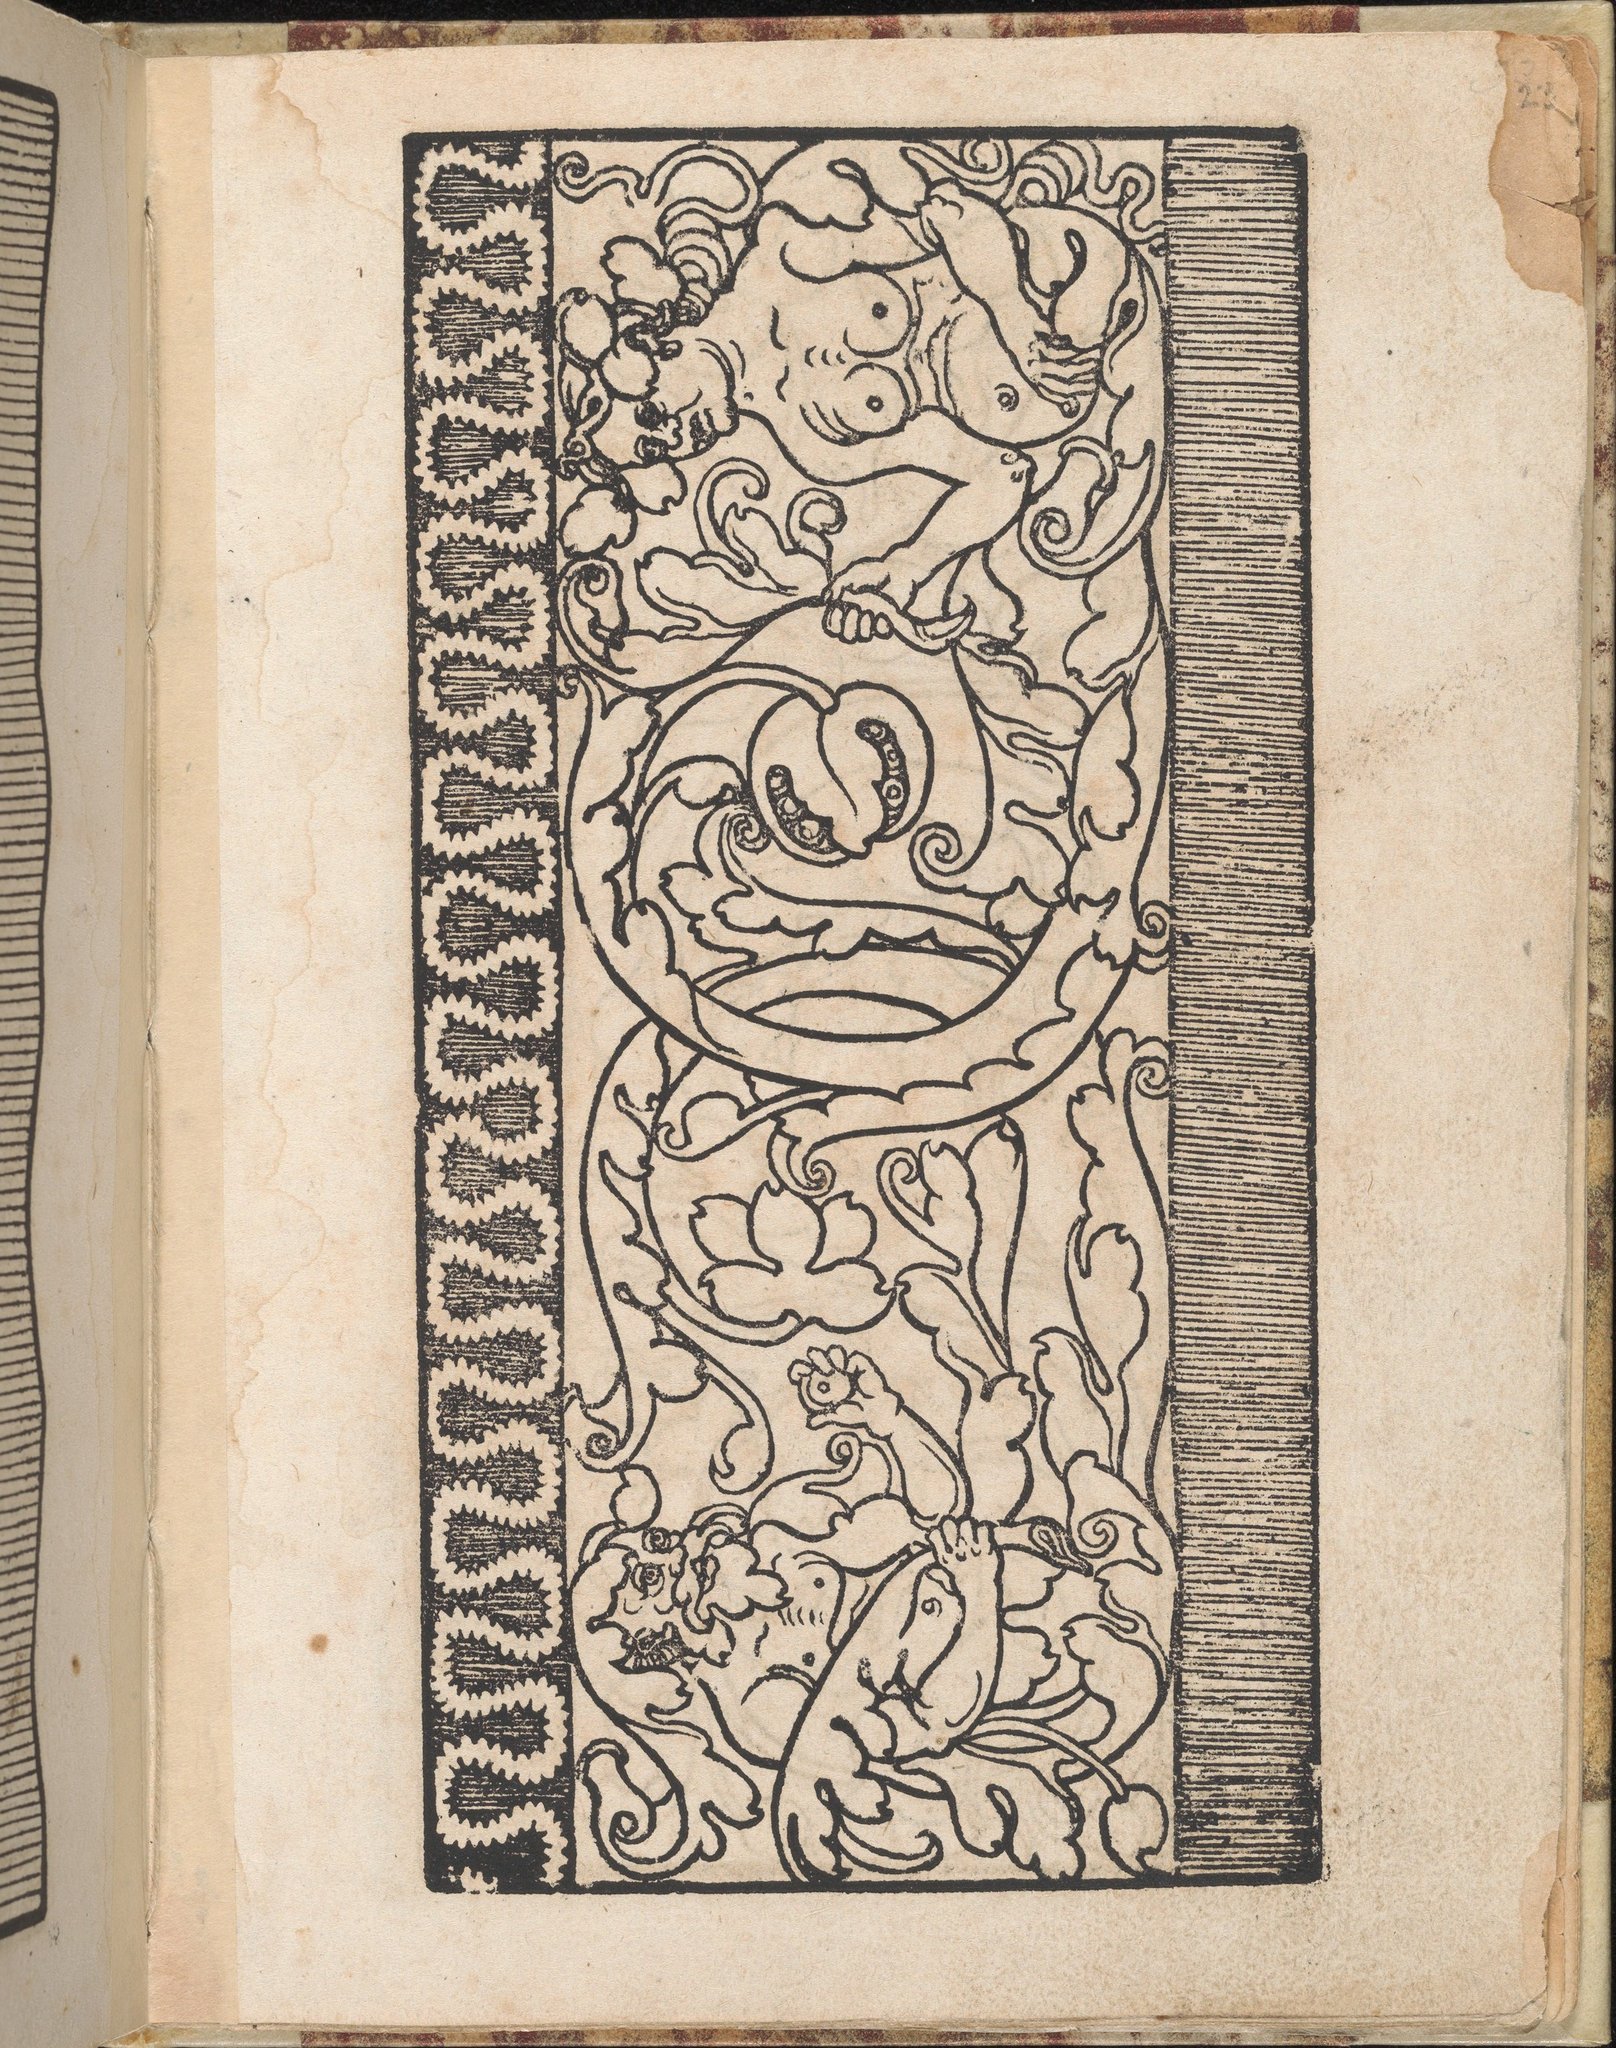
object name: book print ornament architecture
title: Ein new getruckt model Büchli...Page 23, recto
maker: johann schönsperger the younger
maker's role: publisher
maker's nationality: german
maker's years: 1490-1550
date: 1529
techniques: woodcut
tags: flowers